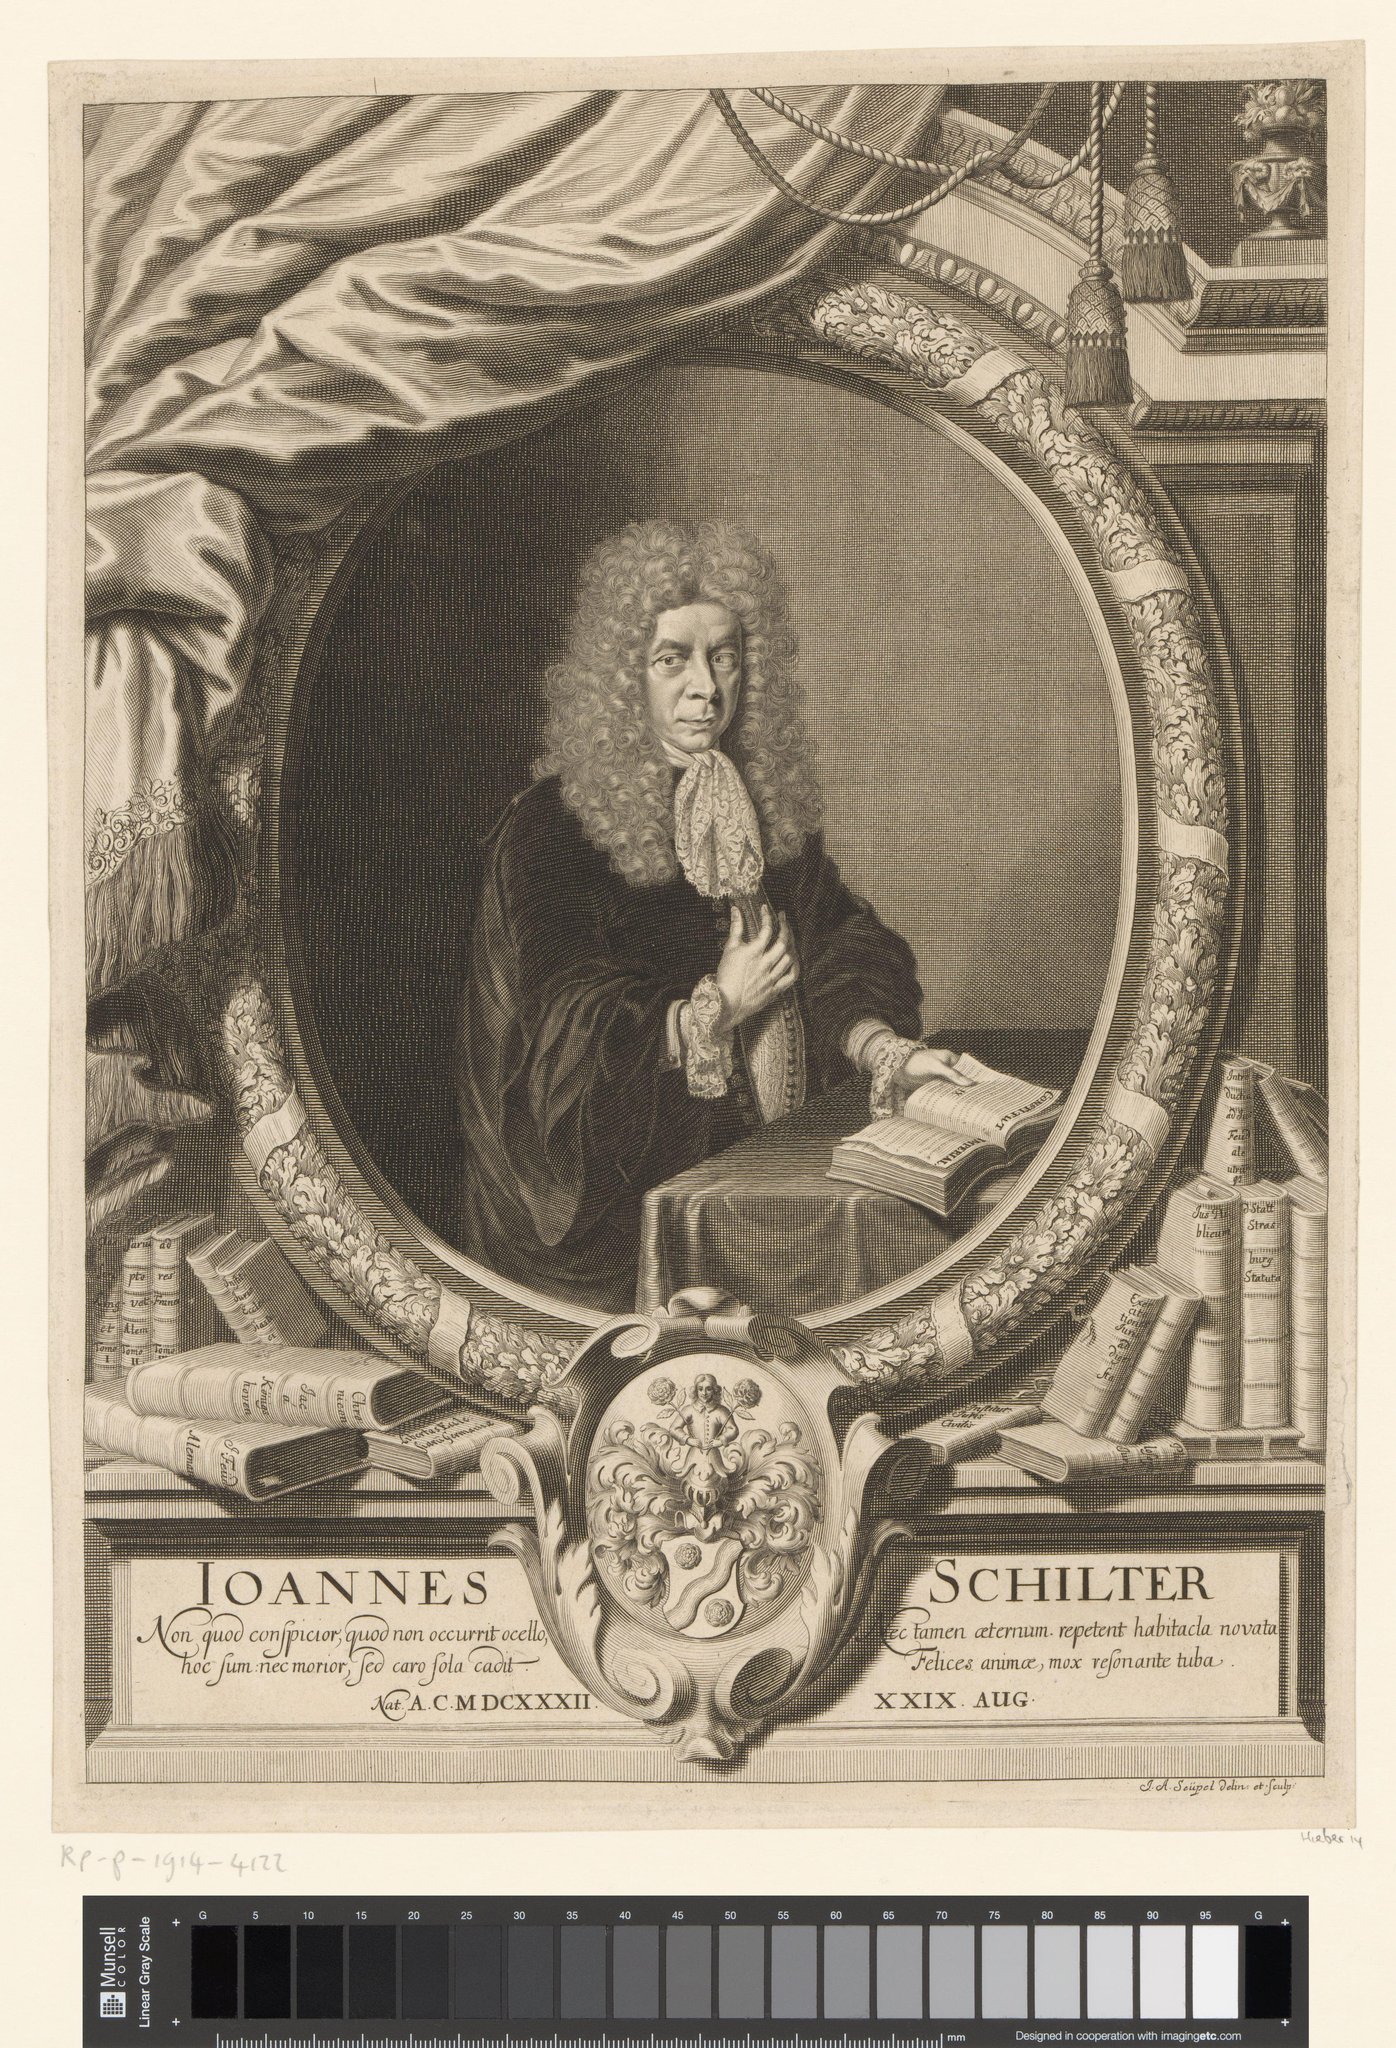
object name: print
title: Portret van Johann Schilter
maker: johann adam seupel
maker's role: painter, print maker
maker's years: 1662-1717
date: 1672-1717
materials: paper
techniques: engraving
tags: historical persons, book, armorial bearing, heraldry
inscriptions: collector's mark: Lugt 2228